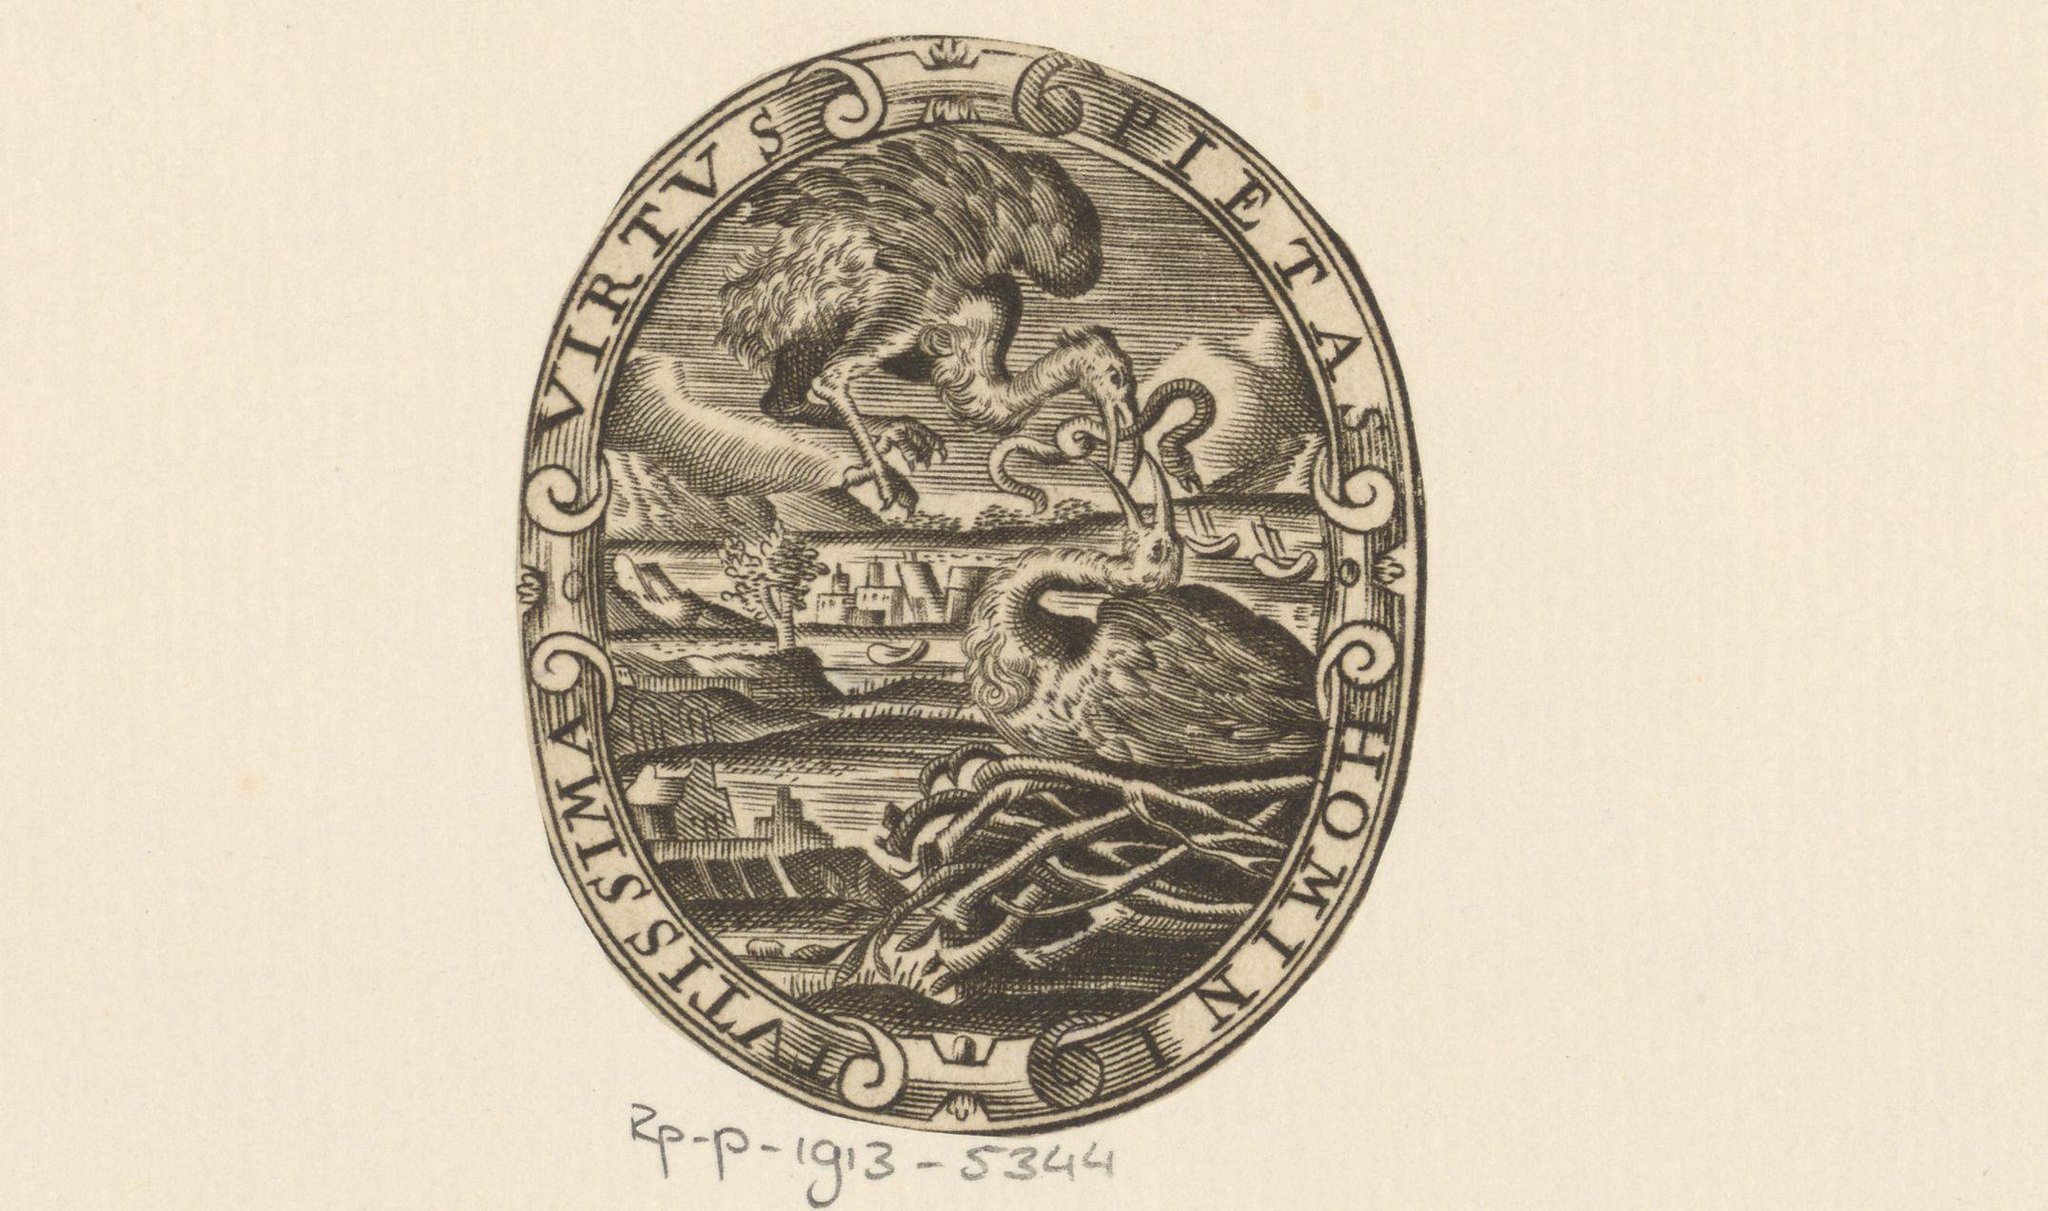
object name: bookplate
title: Ex libris van Jean Baptiste Verdussen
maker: Anonymous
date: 1669-1759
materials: paper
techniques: engraving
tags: birds, animals (+ feeding and care of young)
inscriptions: collector's mark: Lugt 2233, collector's mark: Lugt 2760